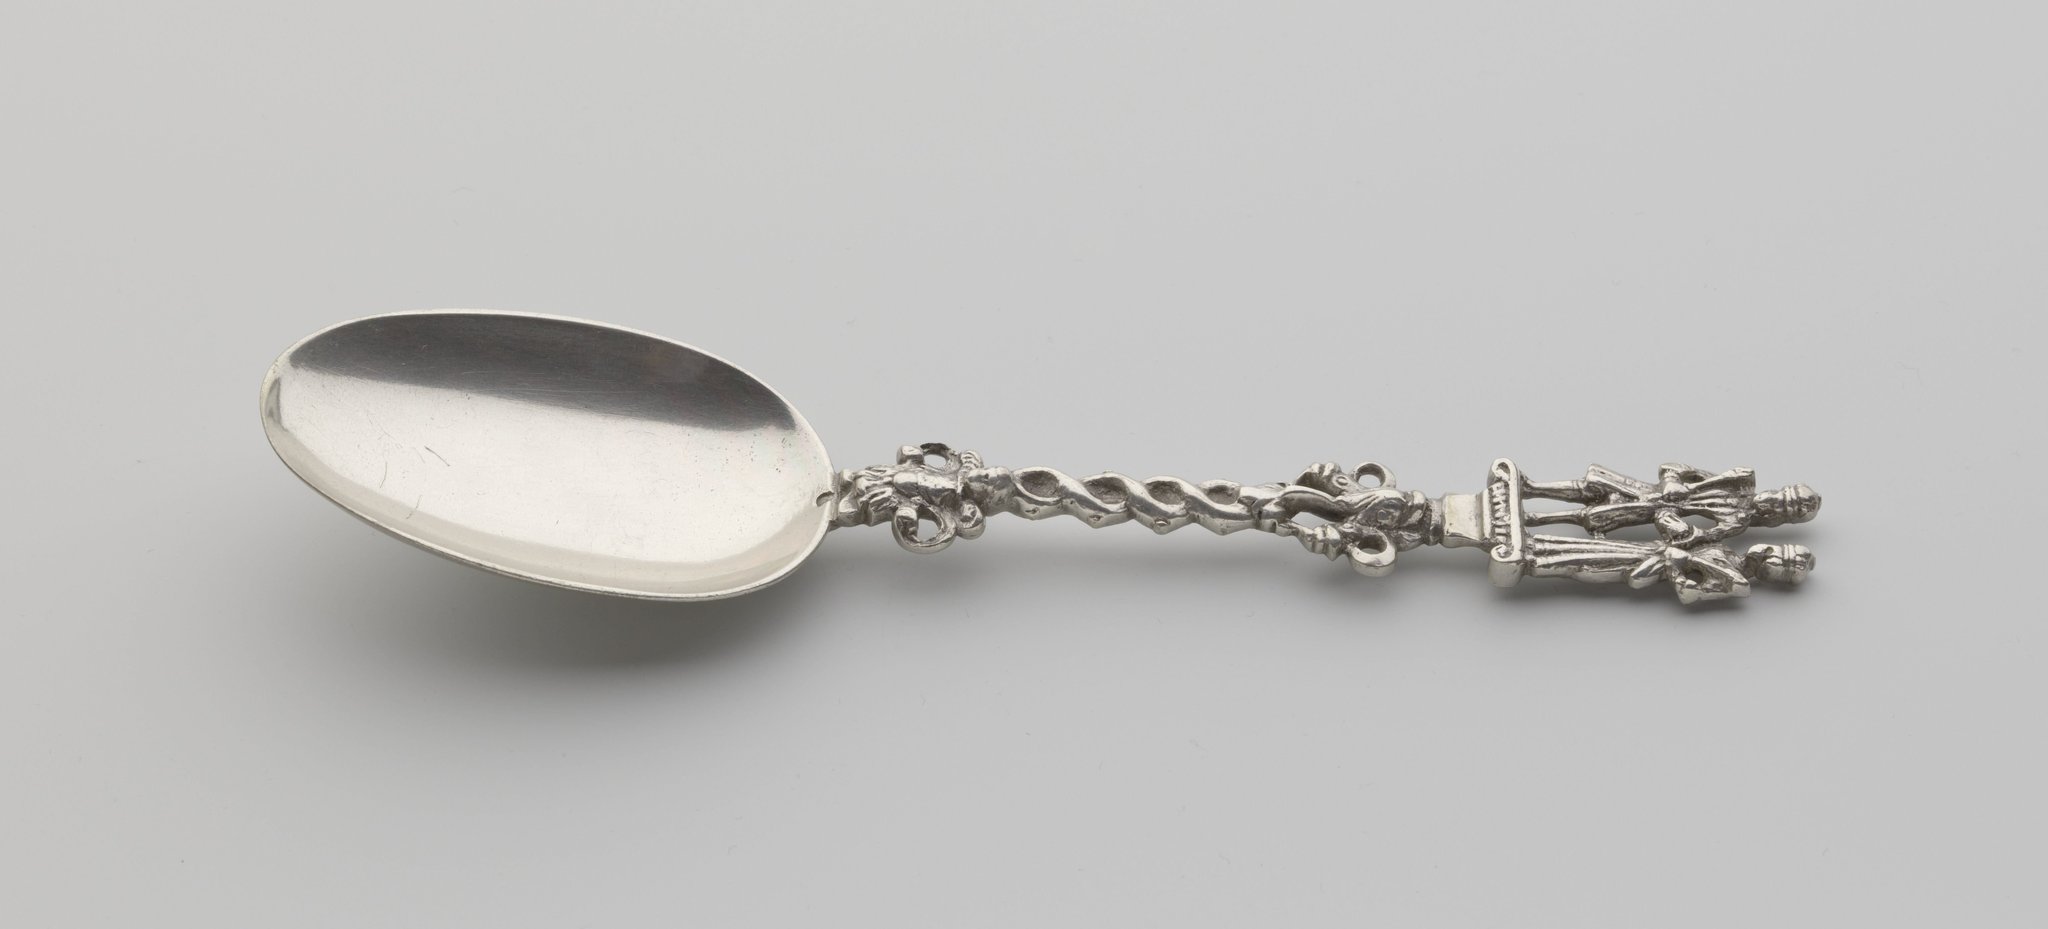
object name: spoon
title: Lepel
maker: Anonymous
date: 1775-1800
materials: silver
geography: amsterdam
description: Een zilveren lepel, met vier dubbel geslingerde takken, en aan de top een koning en een koningin, en een ovale gladde bak. Merken: Een meesterteken, en een klimmende leeuw v. Holland. Eind 18e eeuw, vermoedelijk Amsterdam.